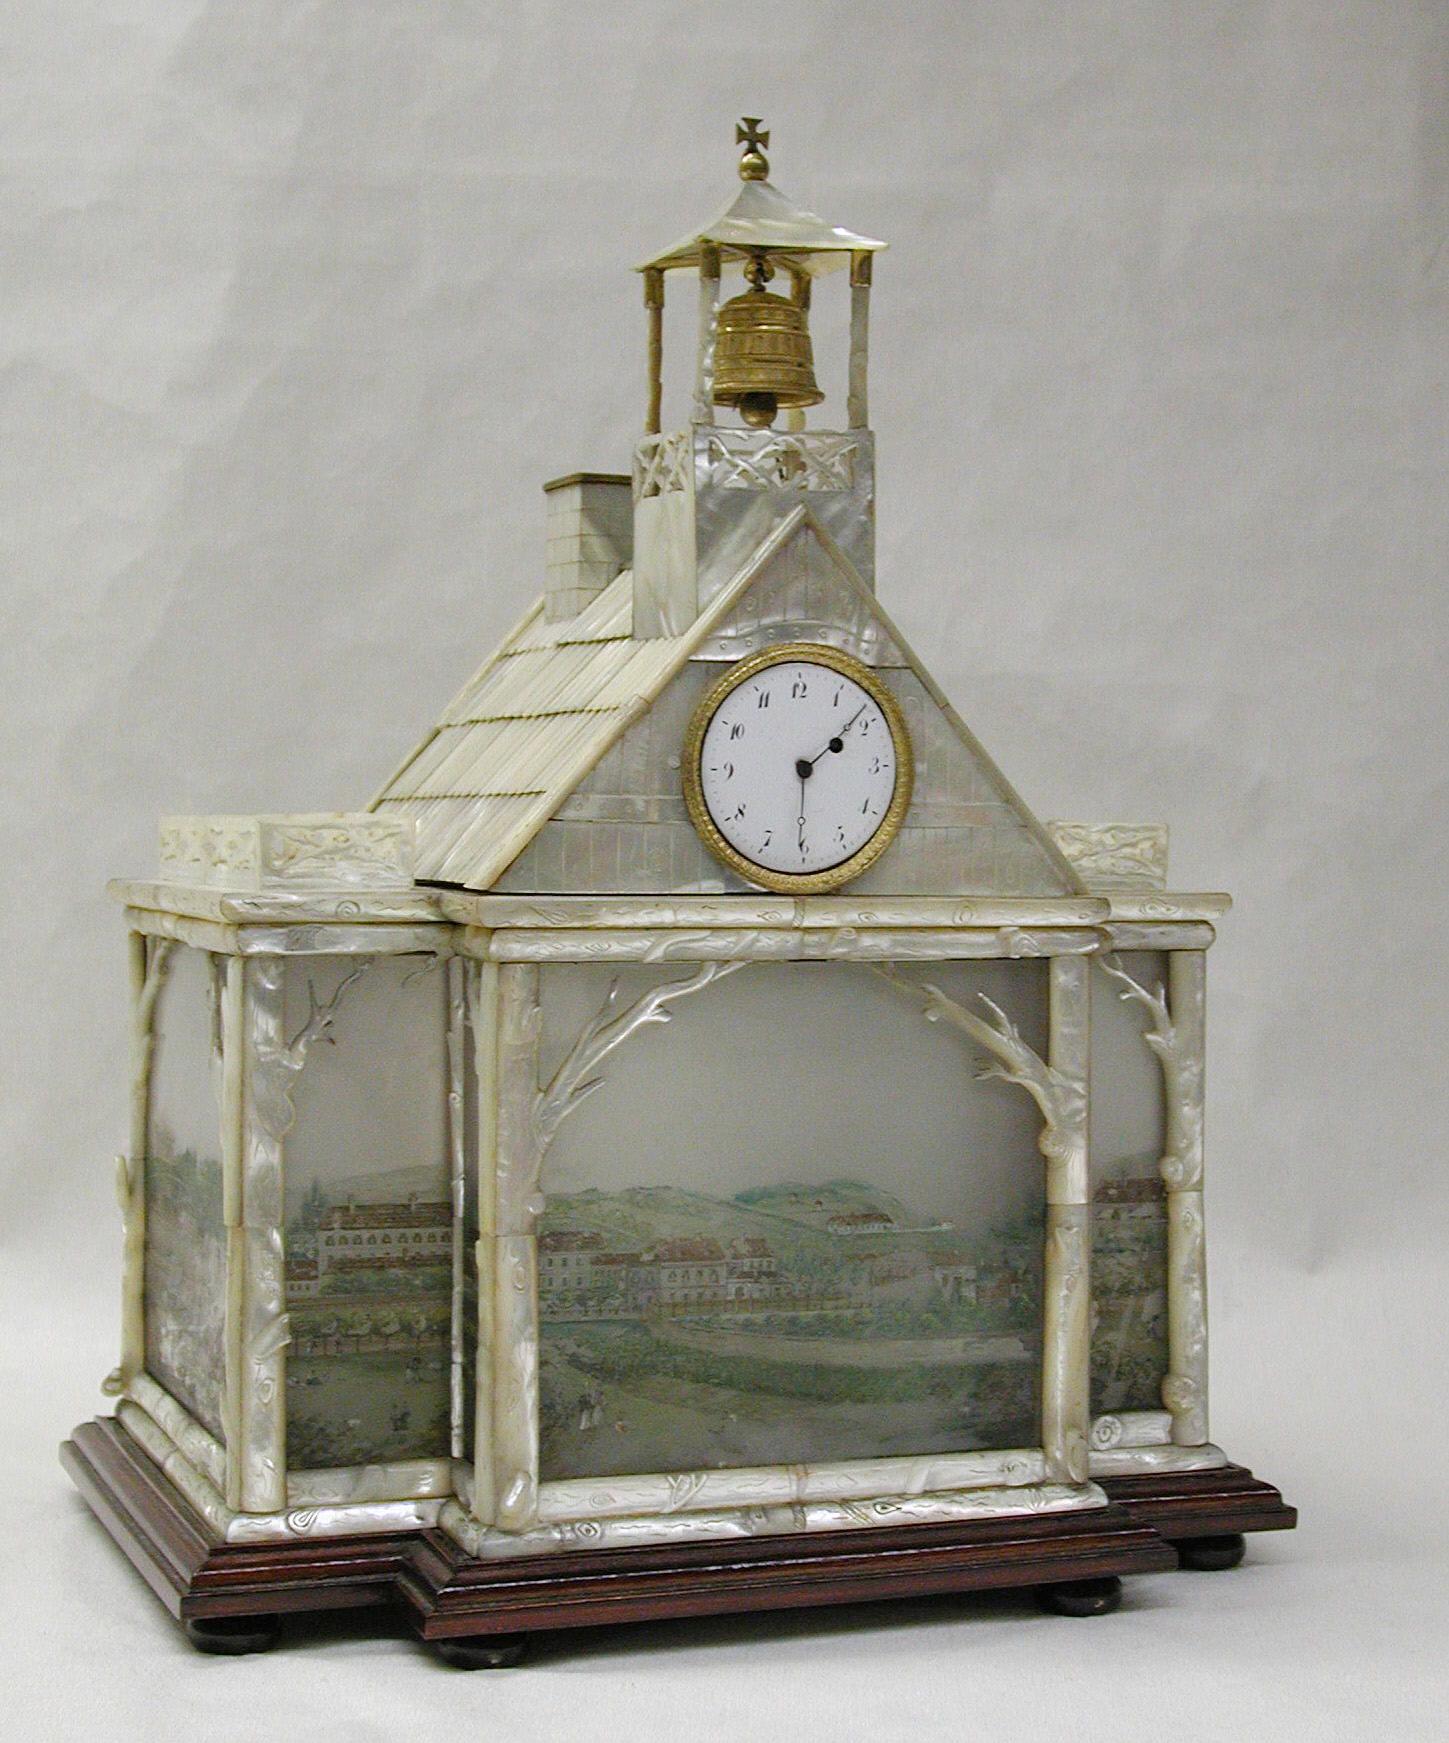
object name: veilleuse with clock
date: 1830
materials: glass, mother of pearl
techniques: painting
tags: human figures,towns,landscapes